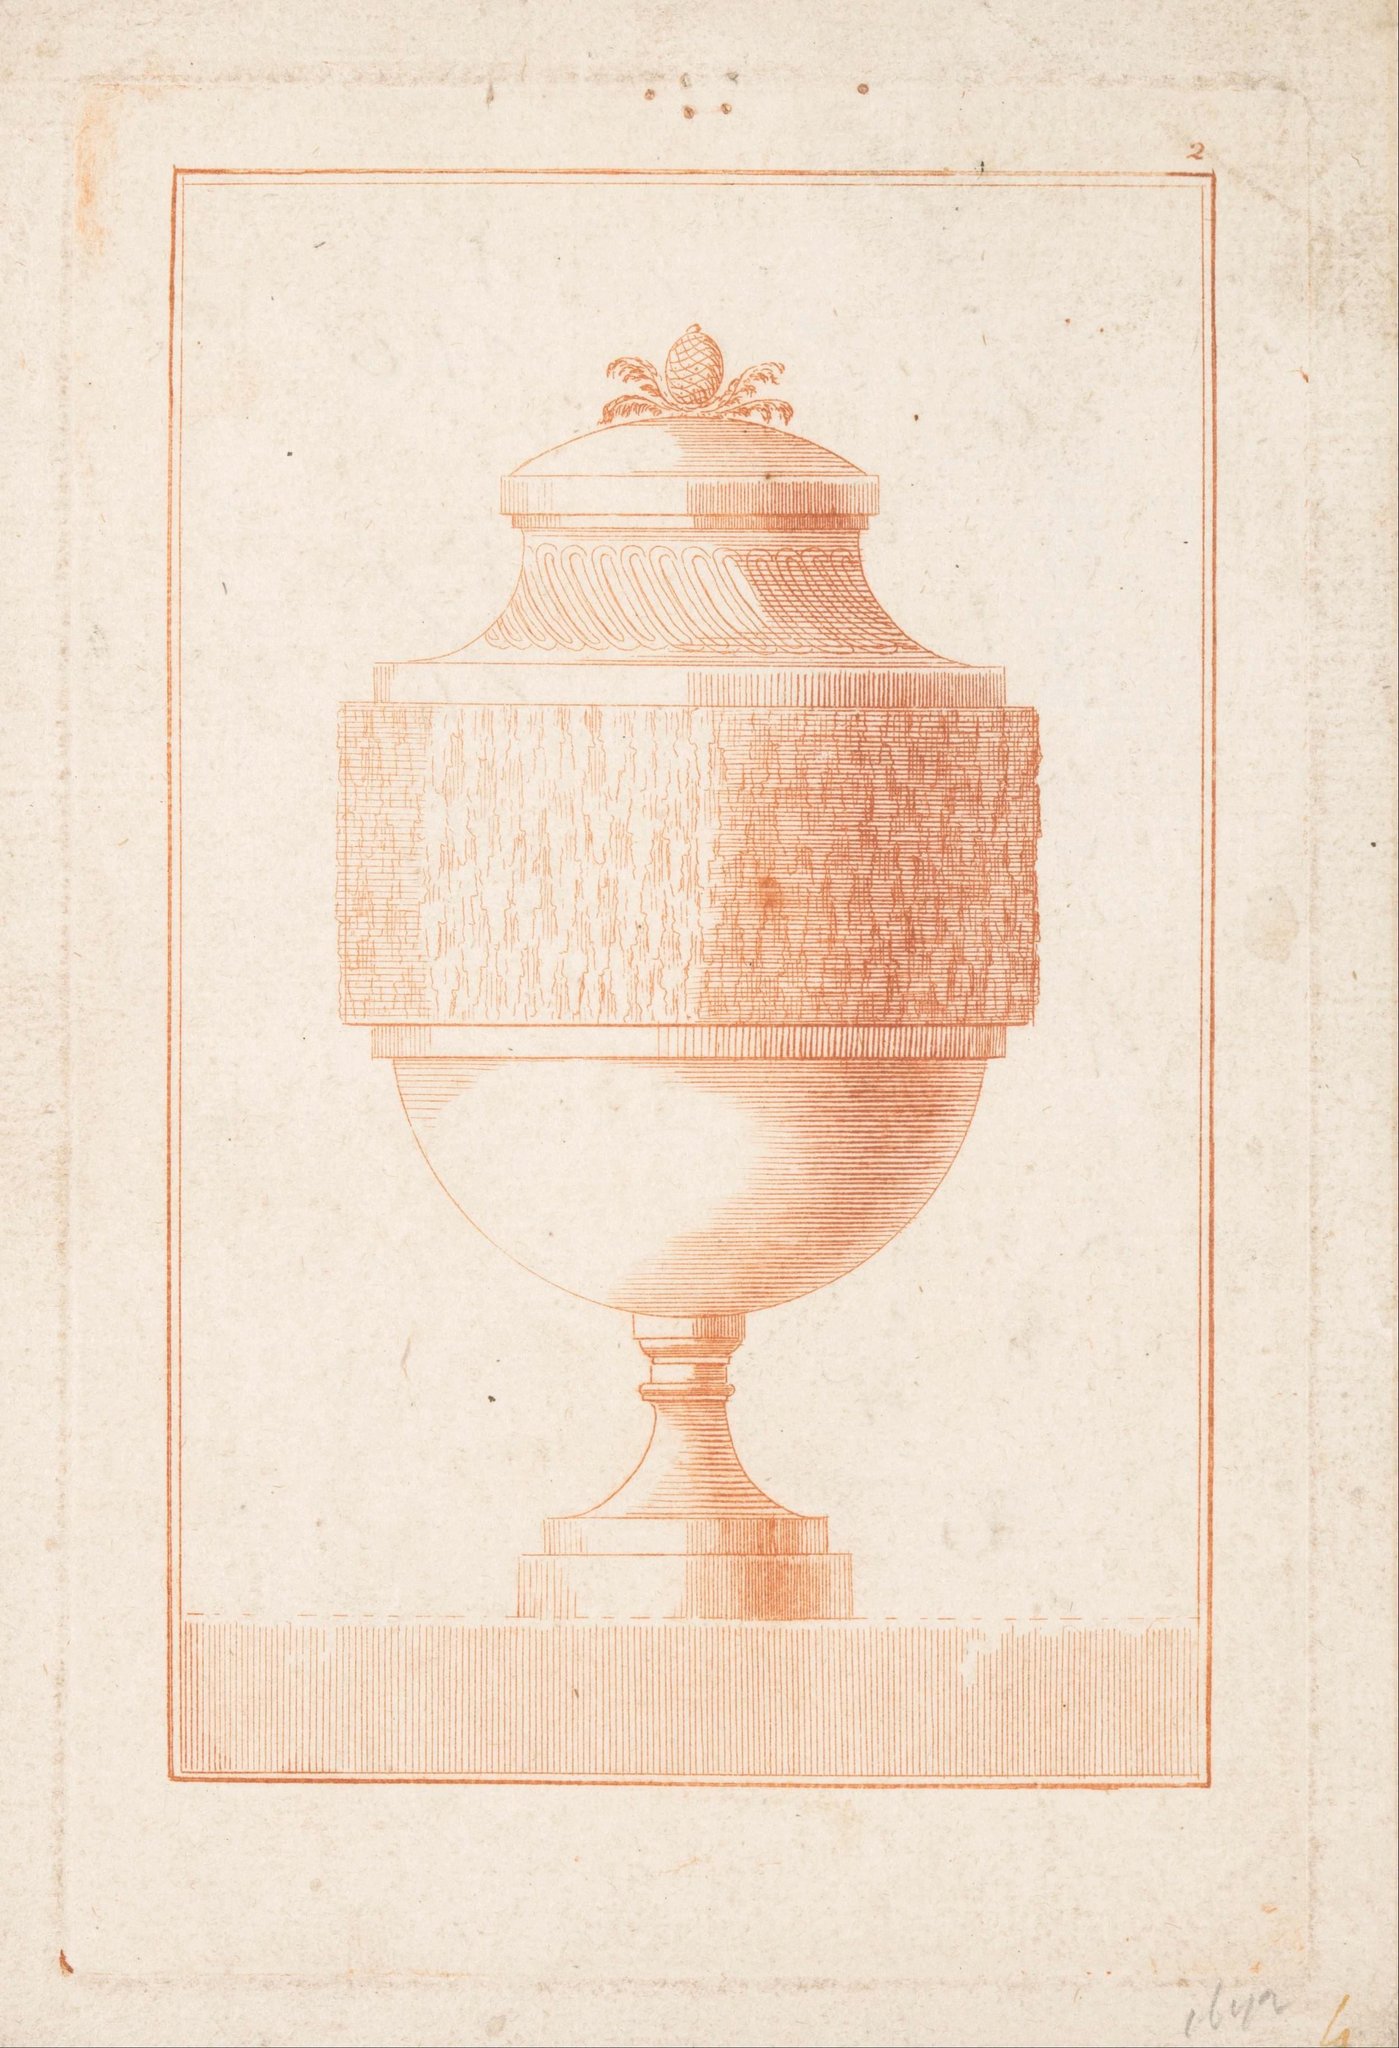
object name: ornament print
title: Vaas met eikel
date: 1760-1780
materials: paper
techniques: etching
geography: paris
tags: vase ~ ornament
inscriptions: collector's mark: Lugt 2228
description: Neoklassieke vaas met deksel. De knop heeft de vorm van een eikel.